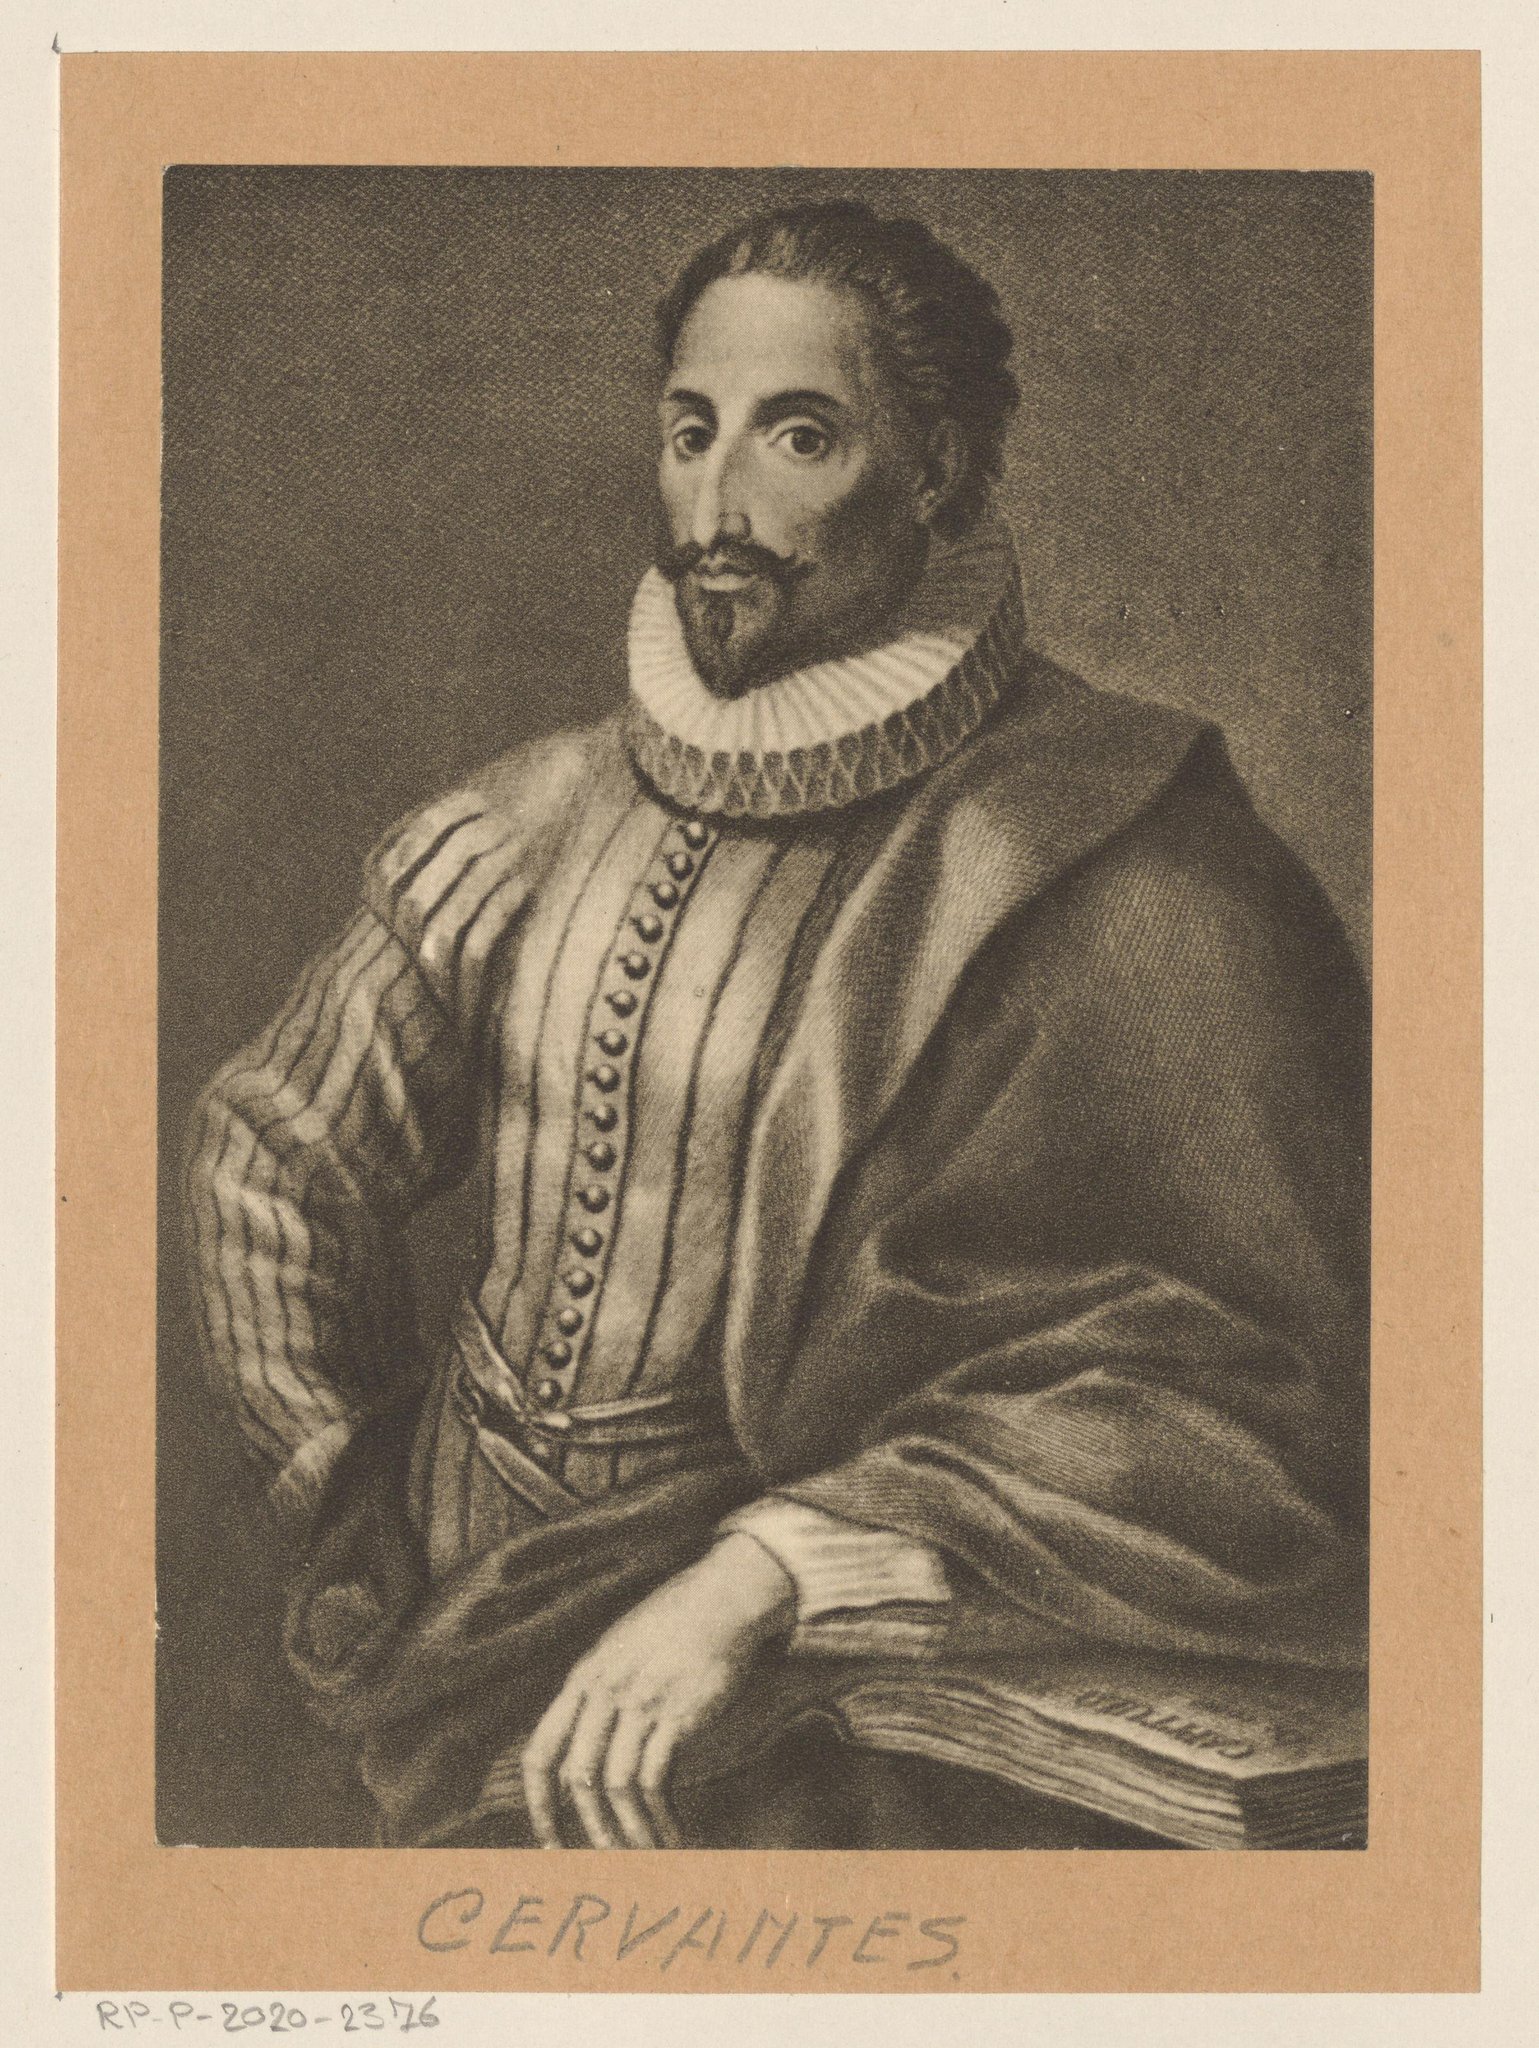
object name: photomechanical print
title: Portret van Miguel de Cervantes Saavedra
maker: Anonymous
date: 1875-1910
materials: paper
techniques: rotogravure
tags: historical persons